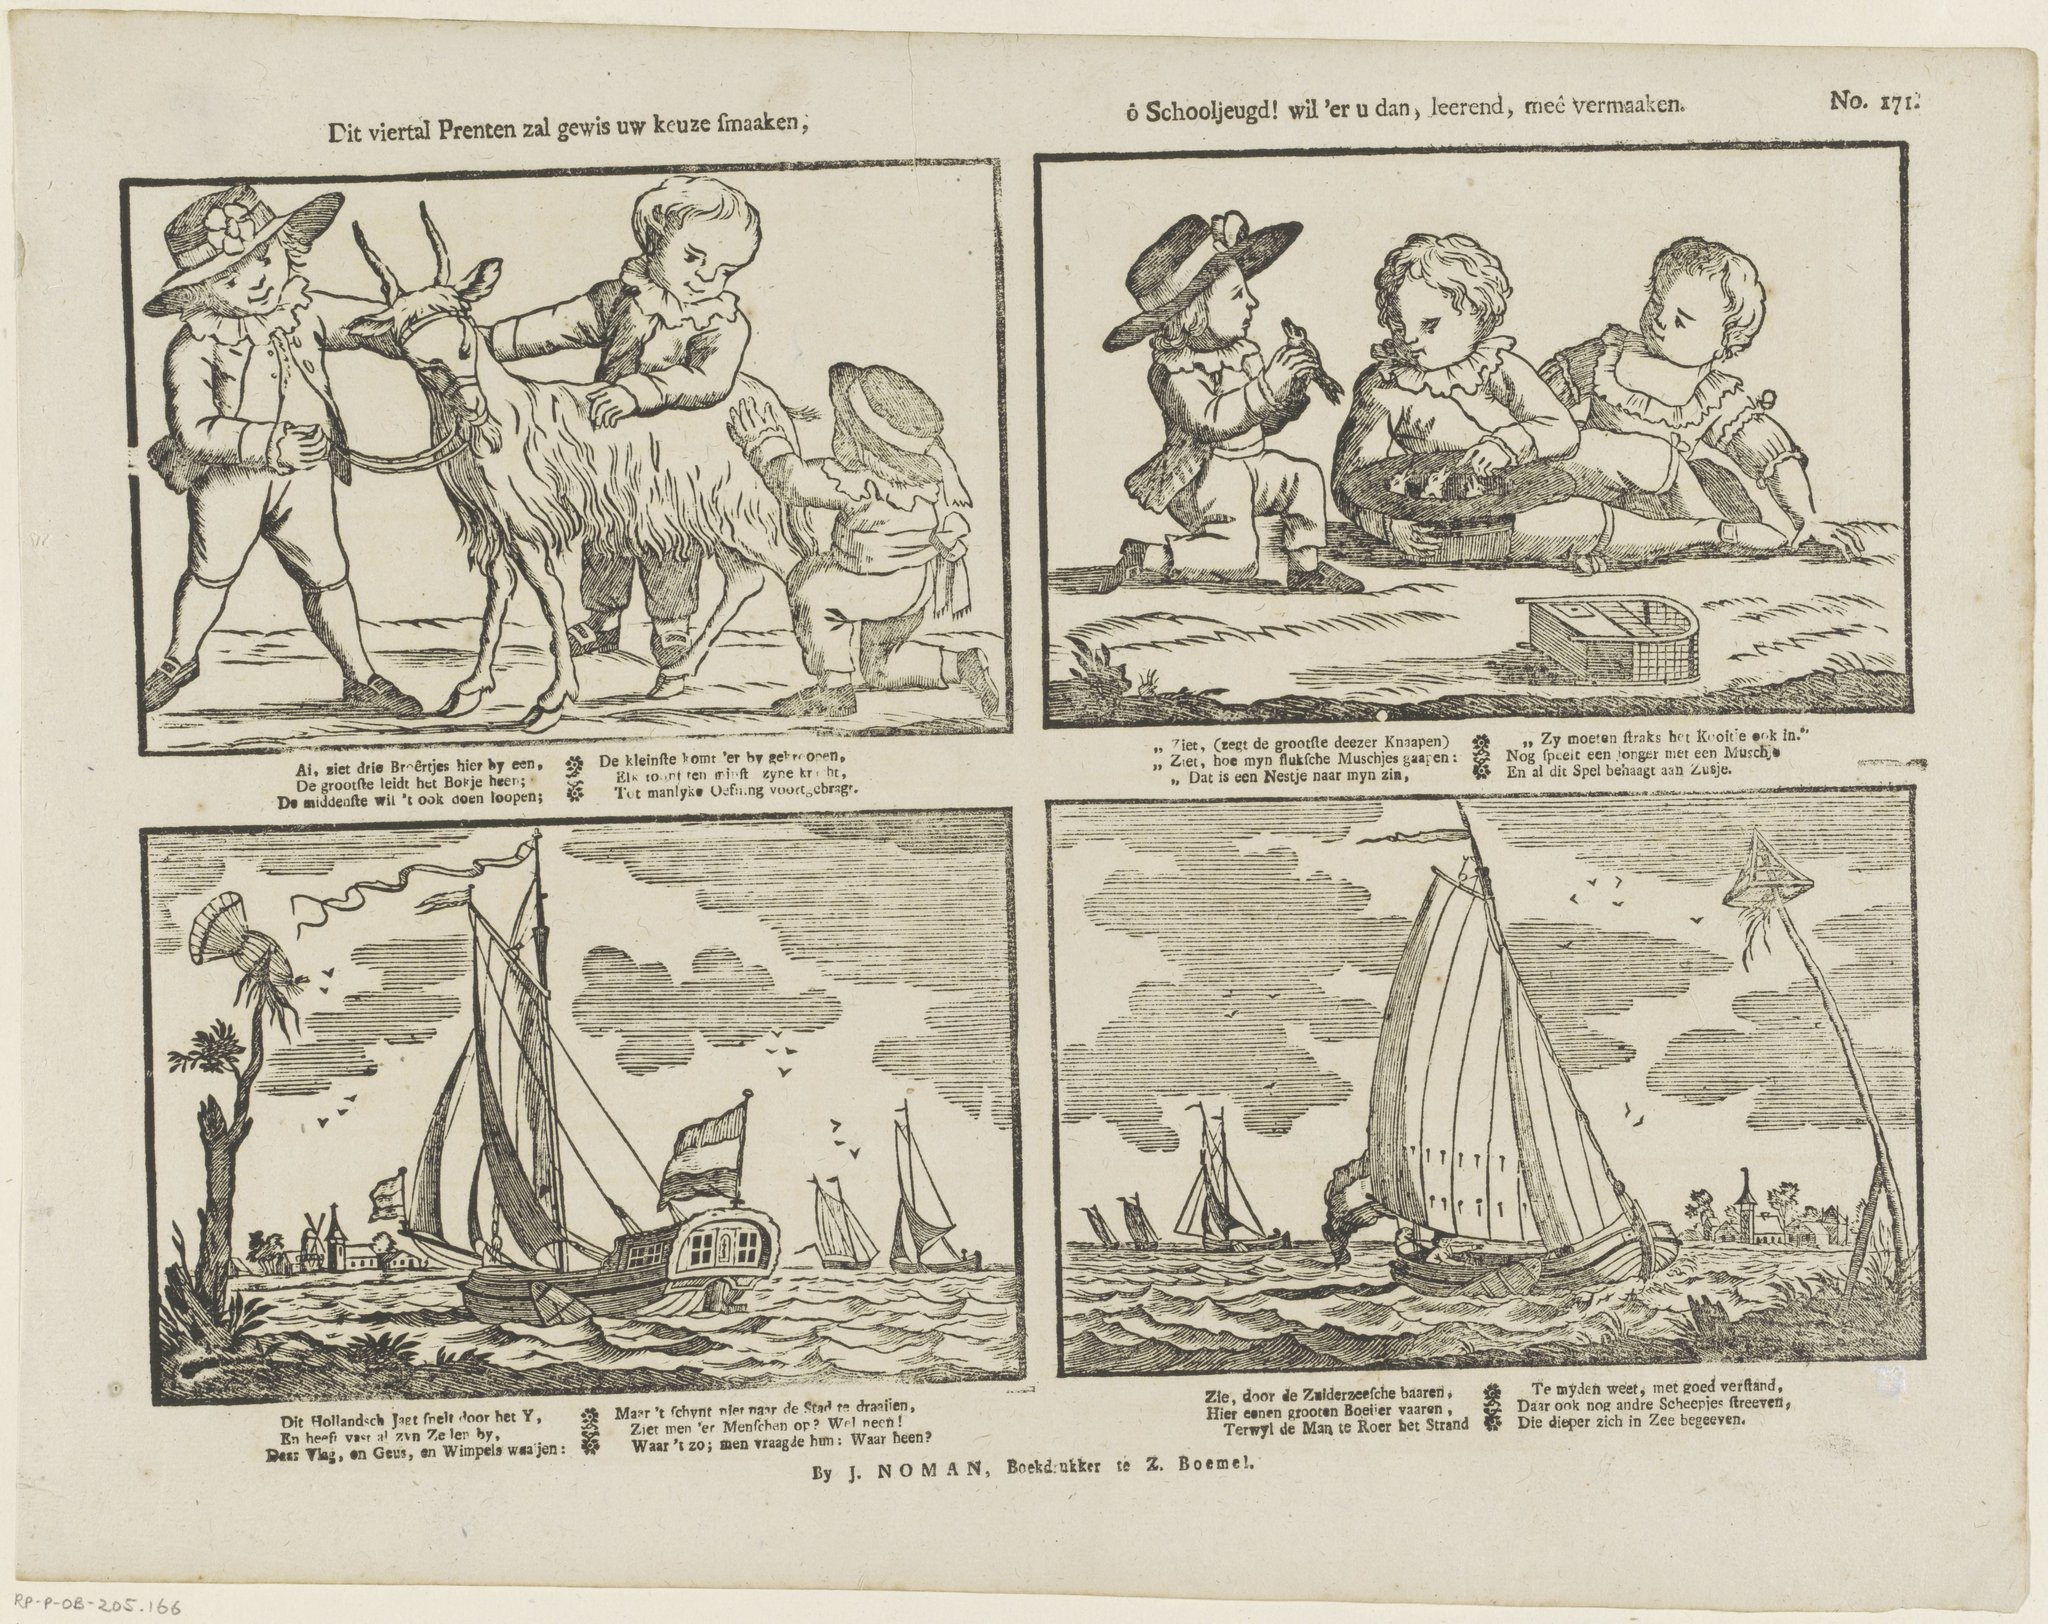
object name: print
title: Dit viertal prenten zal gewis uw keuze smaaken, / ô schooljeugd! wil 'er u dan, / meê vermaaken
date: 1806-1830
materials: paper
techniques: letterpress printing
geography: zaltbommel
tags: ships (in general), child playing with animals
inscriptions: collector's mark: Lugt 2760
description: Blad met 4 voorstellingen. Boven: twee voorstellingen van kinderen die met dieren spelen. Onder: twee voorstellingen van Hollandse zeilschepen. Onder elke afbeelding een zesregelig vers in twee kolommen. Genummerd rechtsboven: No. 171.